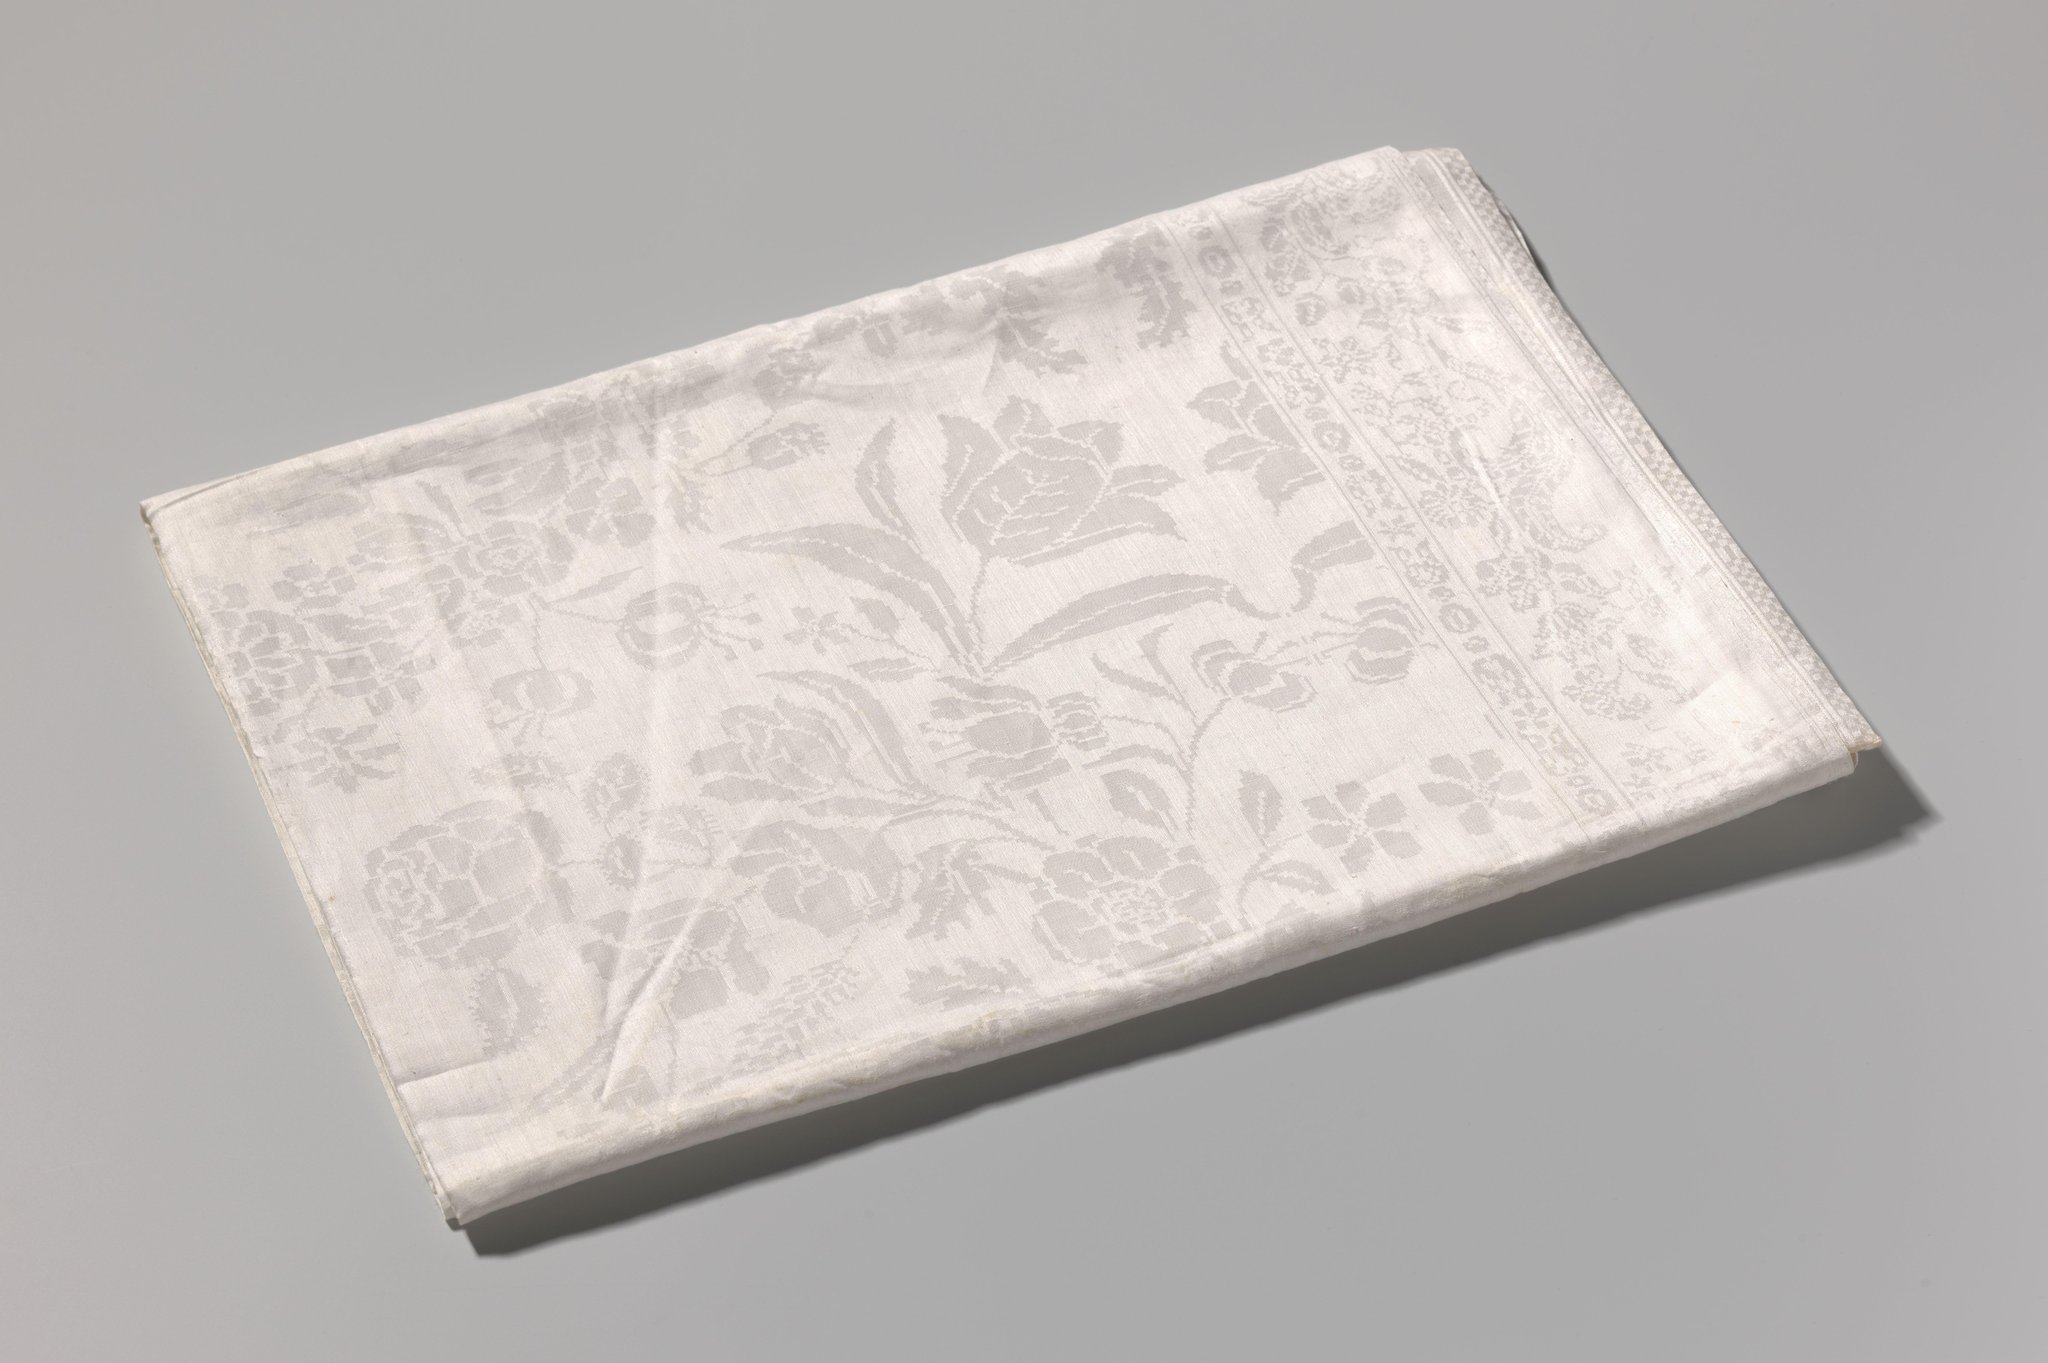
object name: woven material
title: Handdwaal van twee aan elkaar genaaide stukken linnendamast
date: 1670-1680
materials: linen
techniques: damask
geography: northern netherlands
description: Handdwaal van linnendamast met een patroon van gestrooide bloemen en randen met cornicopeeën; de dwaal is uit twee stukken samengesteld.